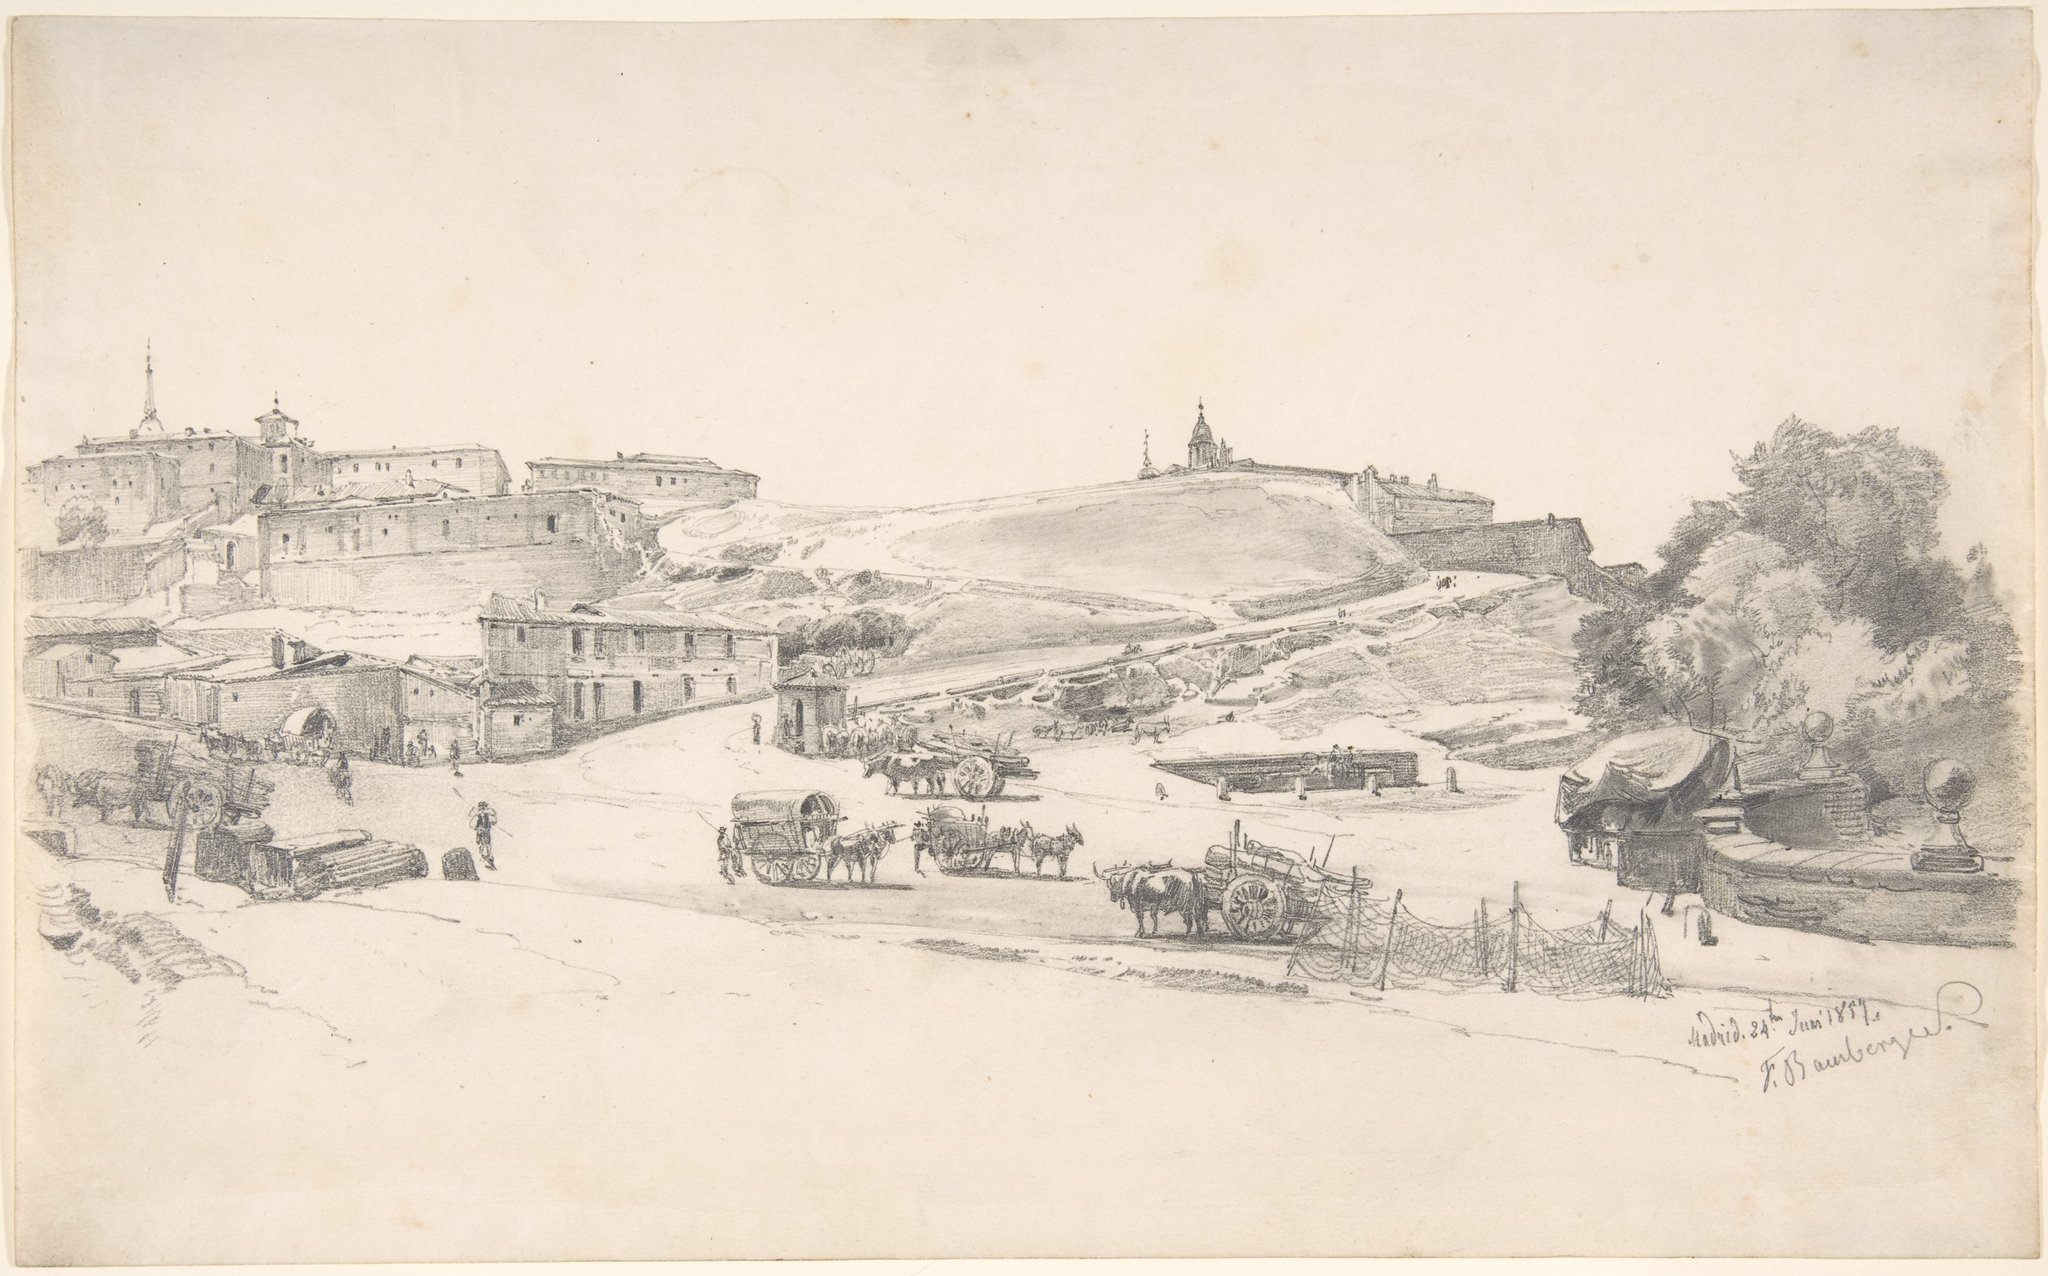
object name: drawing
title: View of the Outskirts of Madrid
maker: fritz bamberger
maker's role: artist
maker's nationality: german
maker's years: 1814-1873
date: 1857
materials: graphite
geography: germany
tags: animals,buildings,roads,trees,carriages